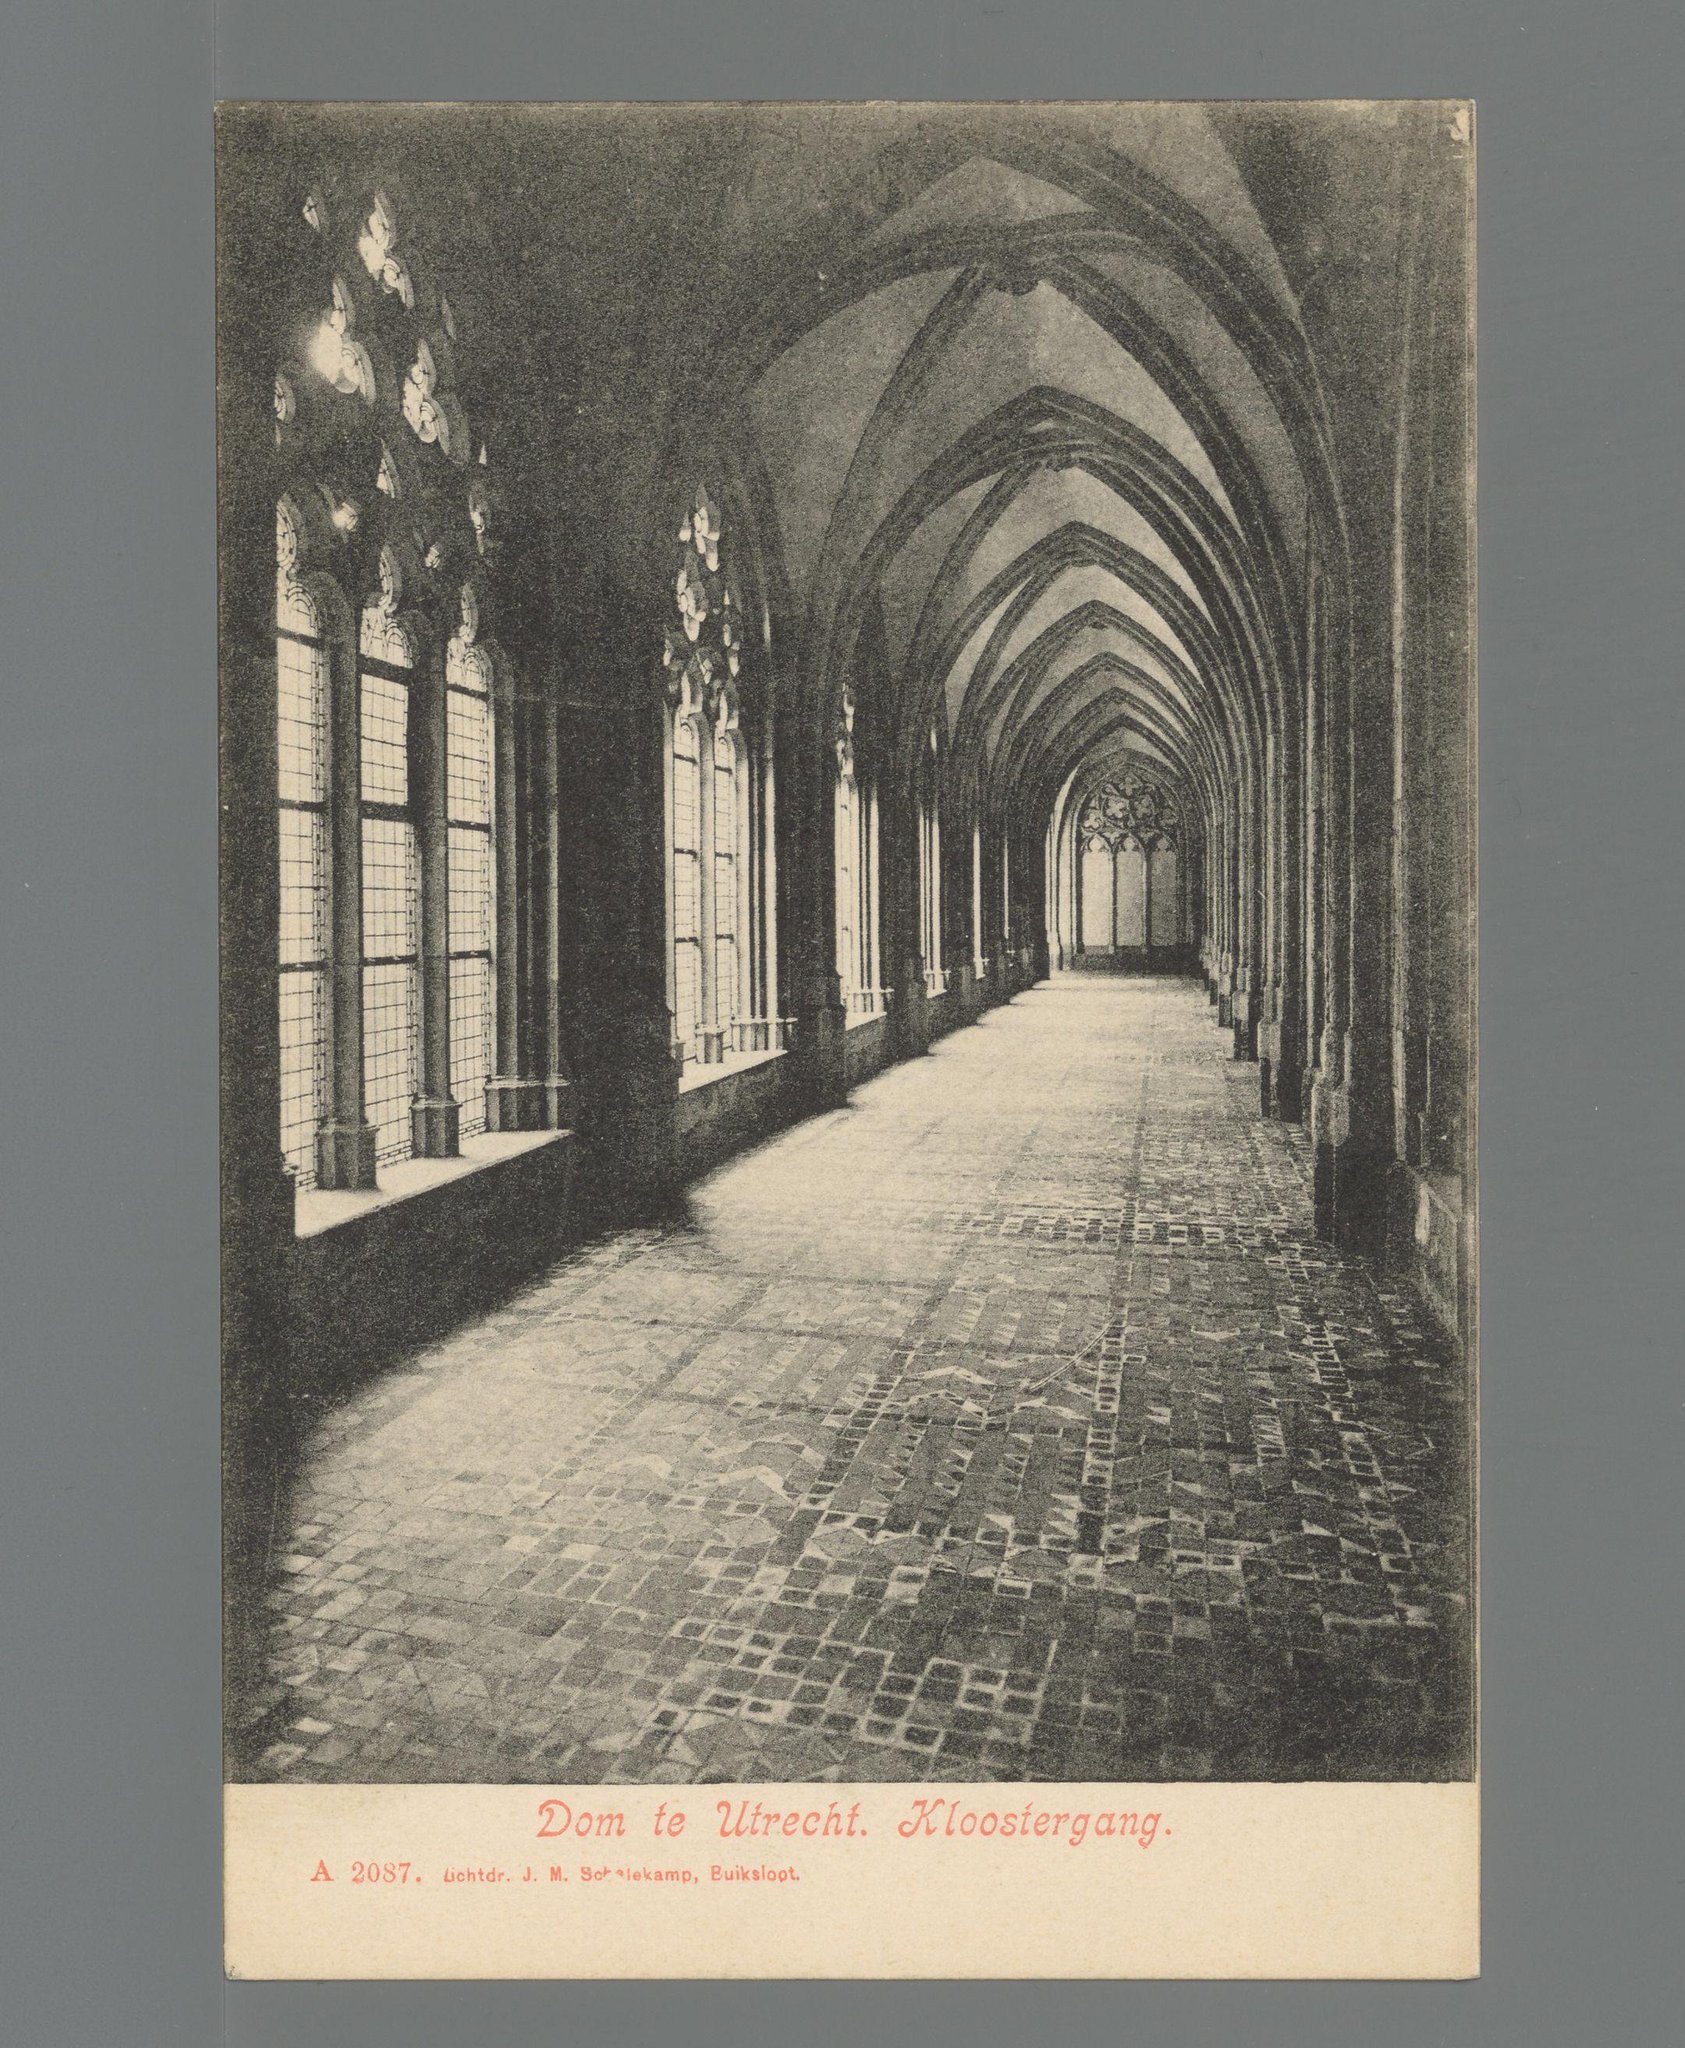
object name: photomechanical print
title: Dom te Utrecht. Kloostergang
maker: johan marinus schalekamp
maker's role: publisher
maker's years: 1844-1912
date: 1897-1910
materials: cardboard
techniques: photograph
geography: buiksloot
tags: corridor, interior of church, vault ~ architecture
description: Vermoedelijk is deze prentbriefkaart oorspronkelijk gedrukt in de periode 1897-1905 en zijn op verso later een deelstreep en lijnen voor het adres bijgedrukt, zodat de kaart na 1905 alsnog geldig was en verkocht kon worden.